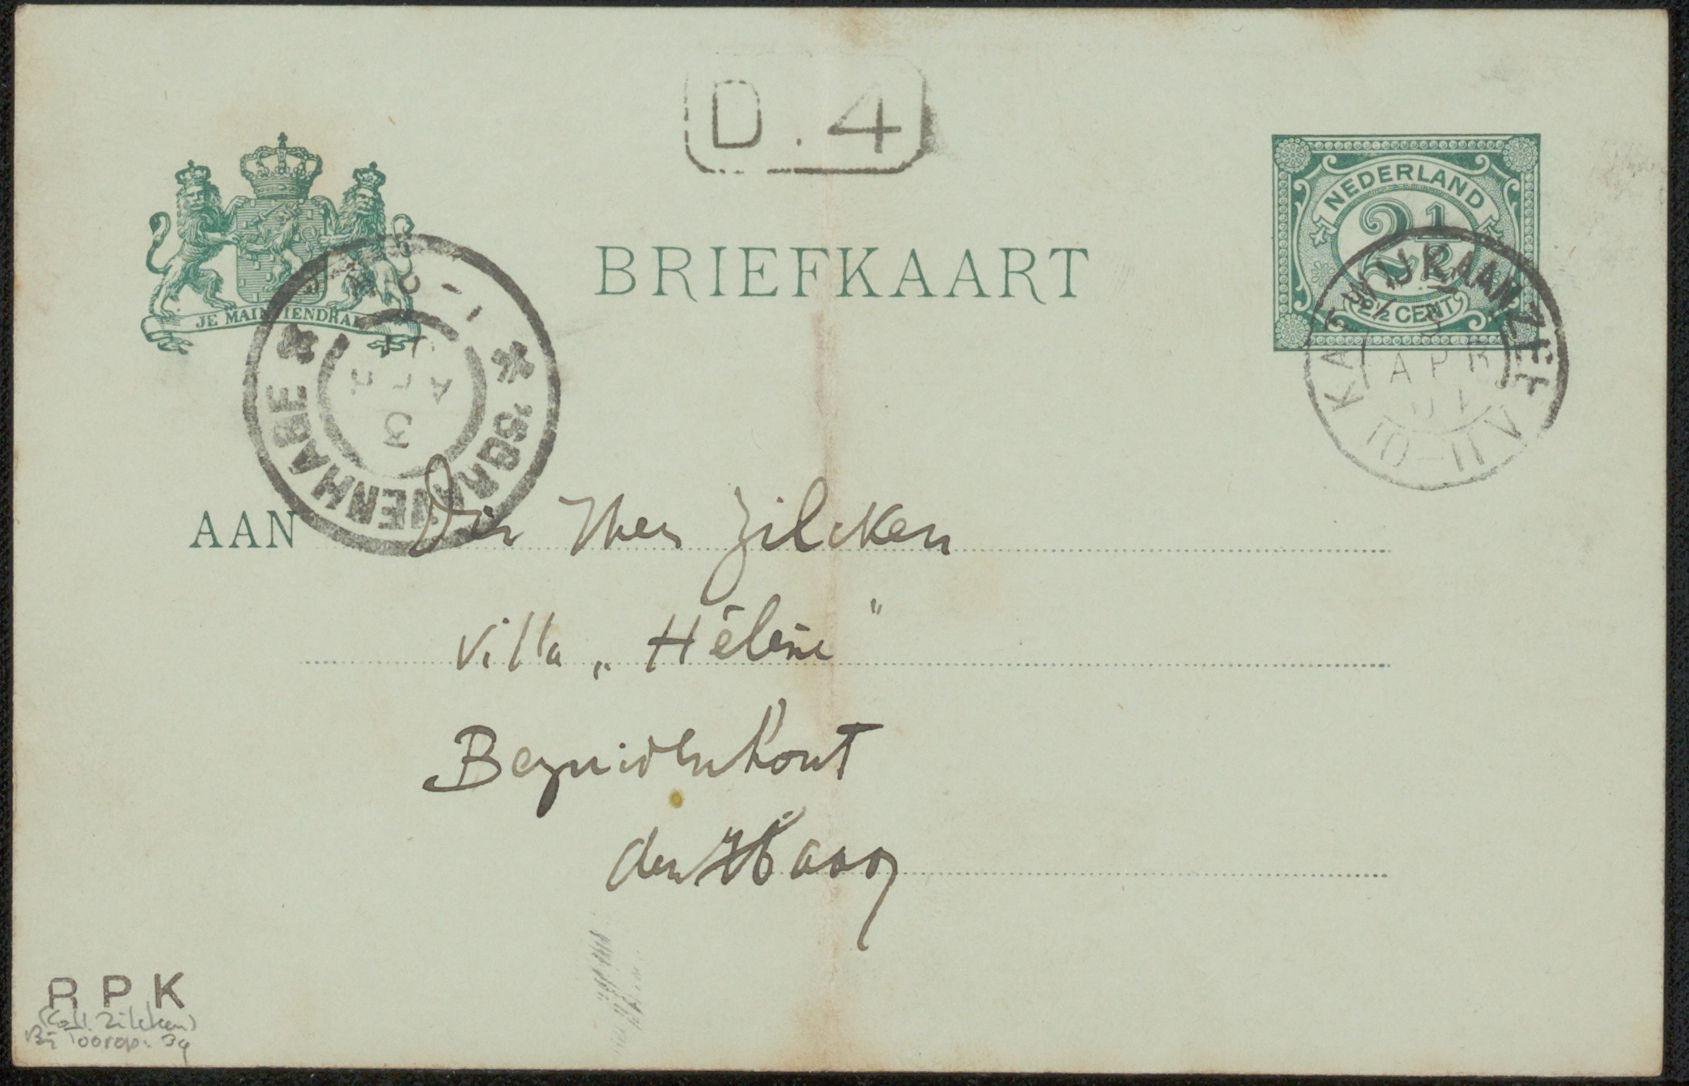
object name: postcard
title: Briefkaart aan Philip Zilcken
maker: jan toorop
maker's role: draughtsman, painter, print maker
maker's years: 1858-1928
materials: cardboard, ink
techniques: pen, writing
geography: katwijk aan zee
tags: constantin emile meunier, voorburg, print maker, renée hélène laure zilcken, draughtsman, édouard vuillard, the hague, philip zilcken, sculpture, painting (including book-illumination, miniature-painting), exhibition ~ art, historical persons (portraits and scenes from the life), rotterdam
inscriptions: collector's mark: ‘RPK’